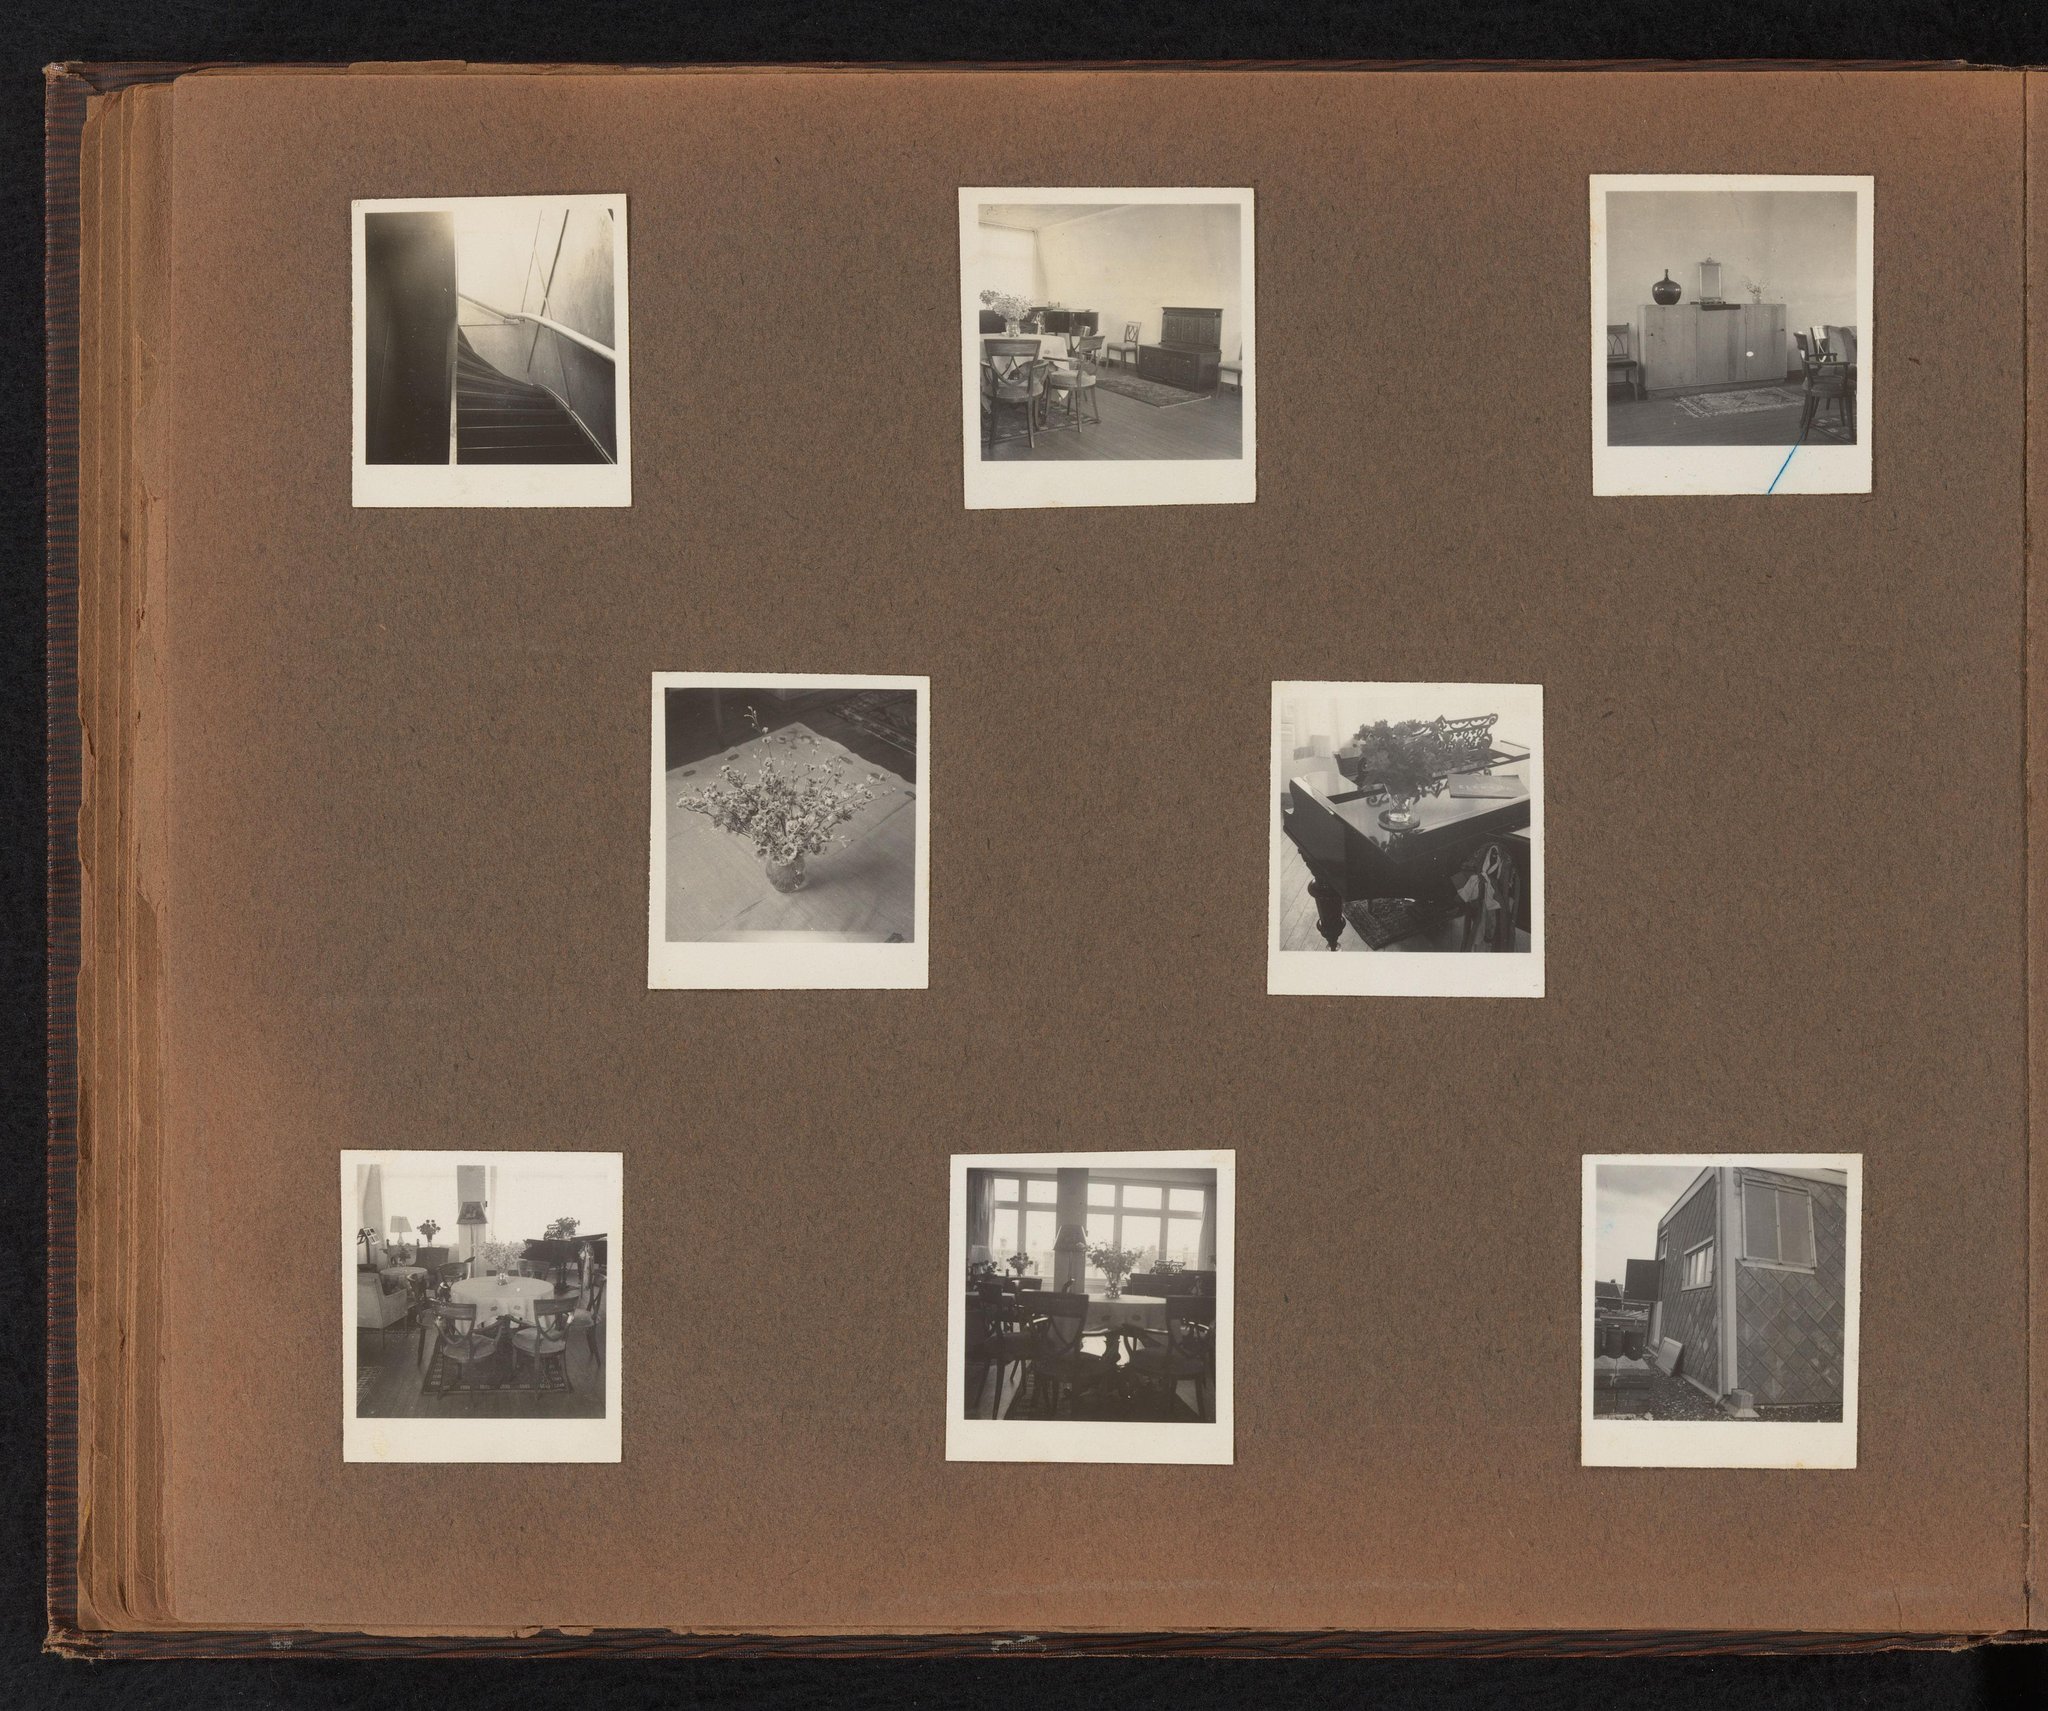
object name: album leaf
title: Bladzijde uit het fotoalbum van de familie Diepenbrock met 8 foto's van Alphons Diepenbrock en zijn omgeving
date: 1909-1920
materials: cardboard, photographic support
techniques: photography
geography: amsterdam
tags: netherlands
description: Bruin albumblad 56 van familiealbum van Alphons Diepenbrock.